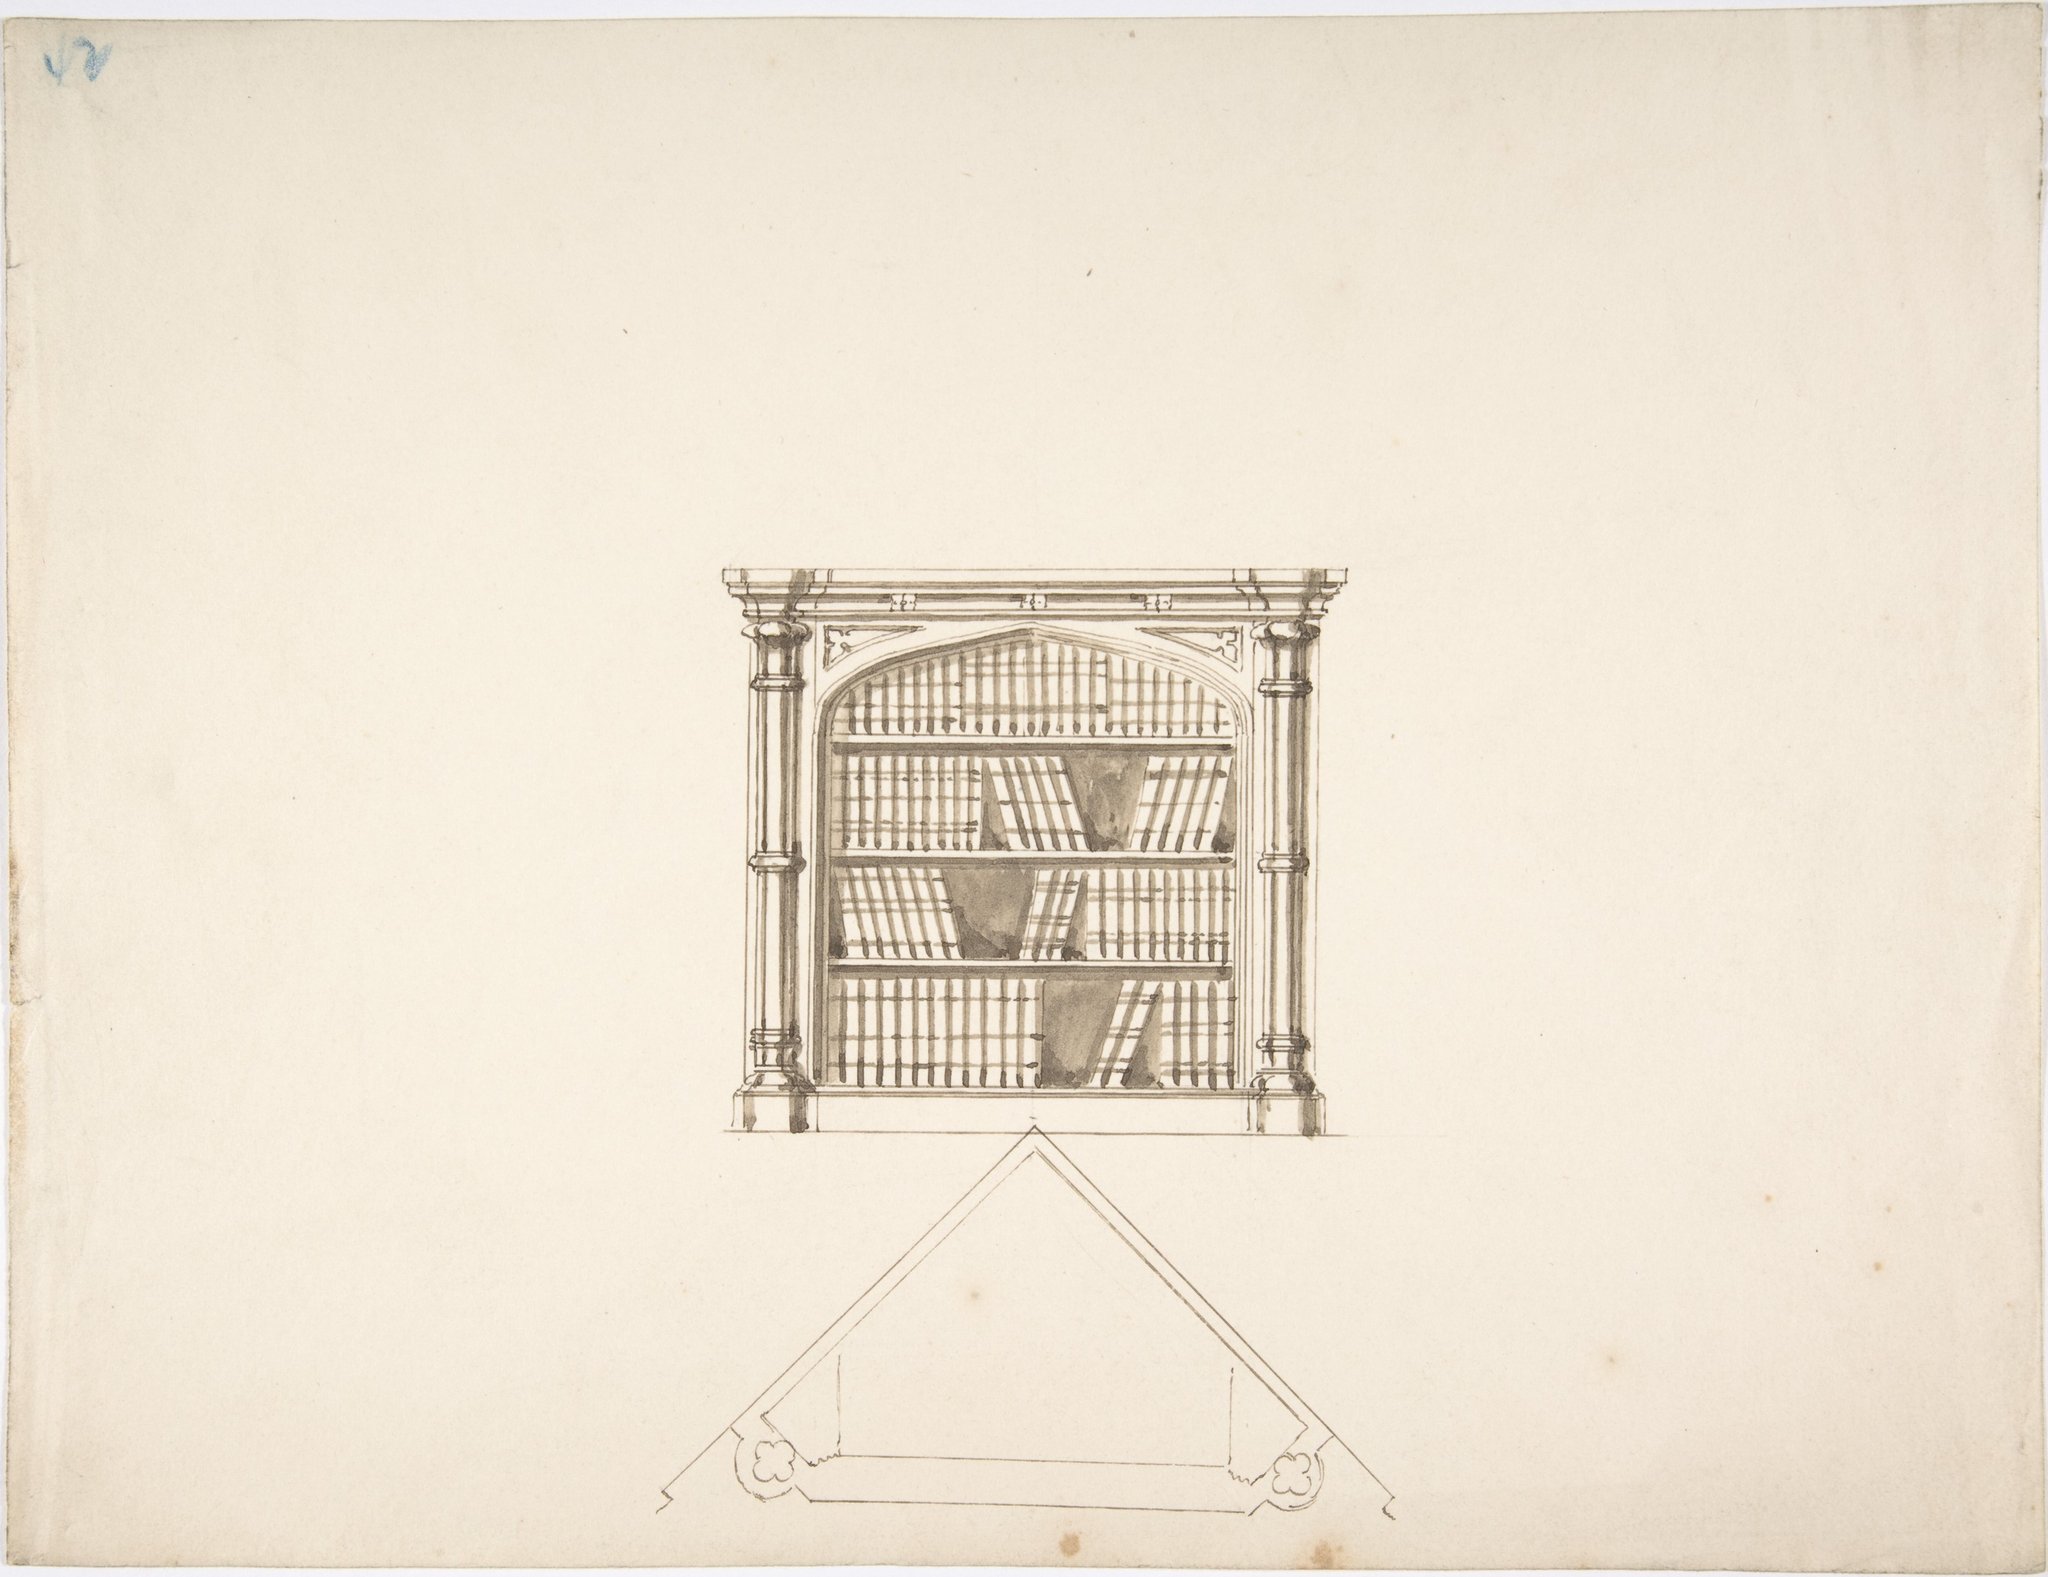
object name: drawing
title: Design for a Gothic Style Corner Book Cabinet: Elevation and Plan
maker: anonymous, british, 19th century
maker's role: artist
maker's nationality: british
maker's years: 1800-1900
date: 1801-1833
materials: ink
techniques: brush, pen, wash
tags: books,cabinets